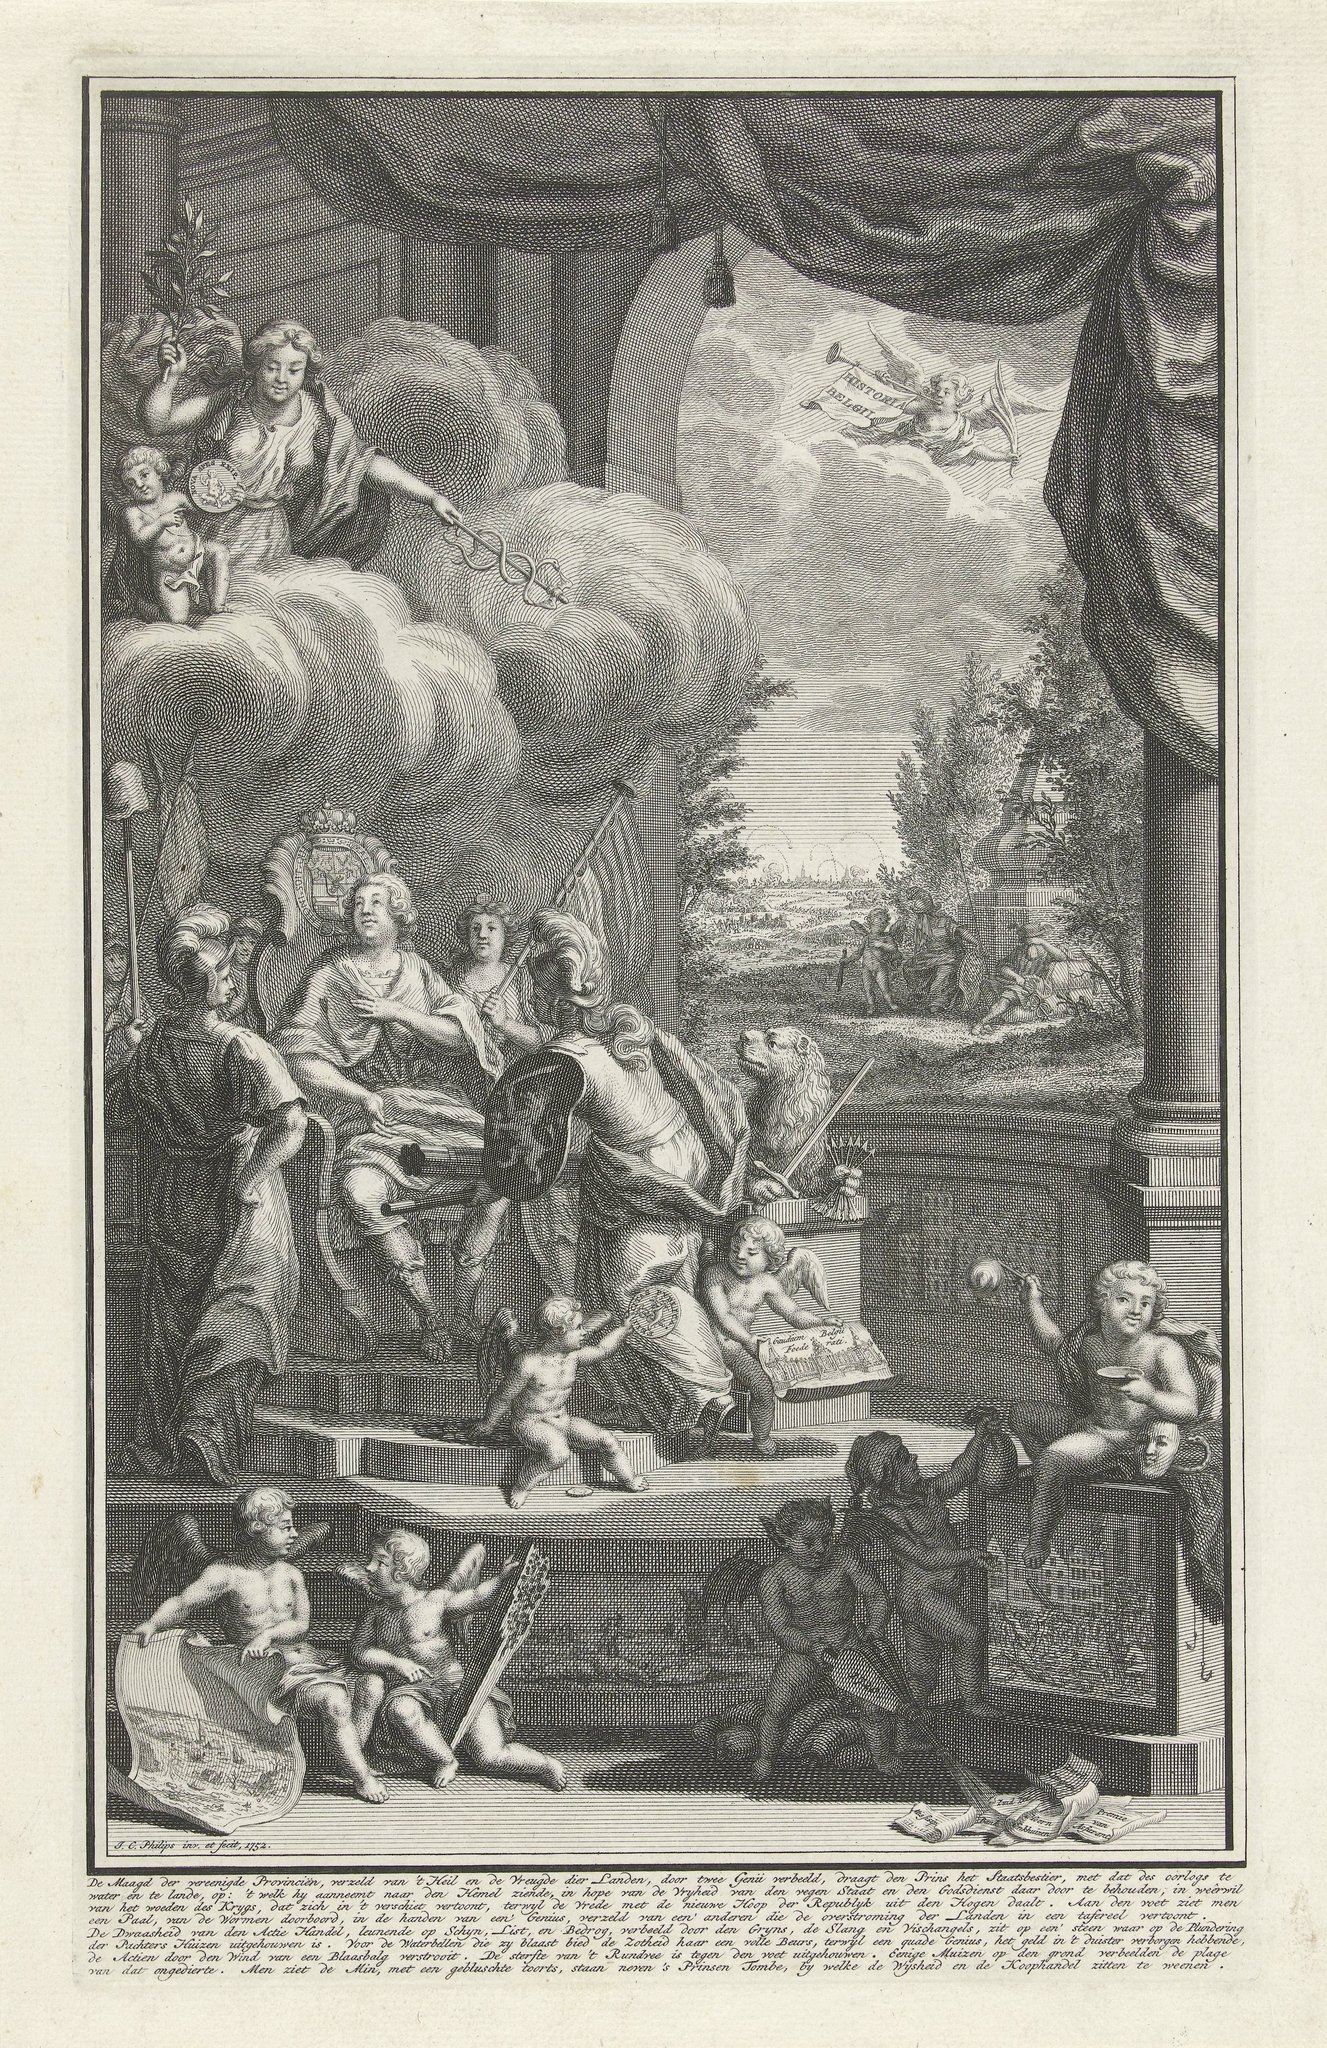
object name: titelblad, titelpagina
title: Titelpagina voor Pieter Le Clercq, Geschiedenissen der Vereenigde Nederlanden, 1753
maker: jan caspar philips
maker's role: draughtsman, print maker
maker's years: 1700-1775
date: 1752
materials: paper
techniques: engraving, etching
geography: northern netherlands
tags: the hague, willem iv (prins van oranje-nassau)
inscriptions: collector's mark: Lugt 2228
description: Allegorische titelprent voor Pieter Le Clercq, Geschiedenissen der Vereenigde Nederlanden, 1753. Stadhouder Wilem IV zittend op troon ontvangt van de Nederlandse Maagd het staatsbestuur. In de wolken de Vrede en blaast de Faam op een bazuin met de vaandel Historia Belgii, op de voorgrond rechts engeltjes die verwijzen naar de Windhandel van 1720. Op de achtergrond treuren Minerva en Mercurius bij de graftombe van de in 1751 overleden prins. In het onderschrift van acht regels een verklaring van de voorstelling.